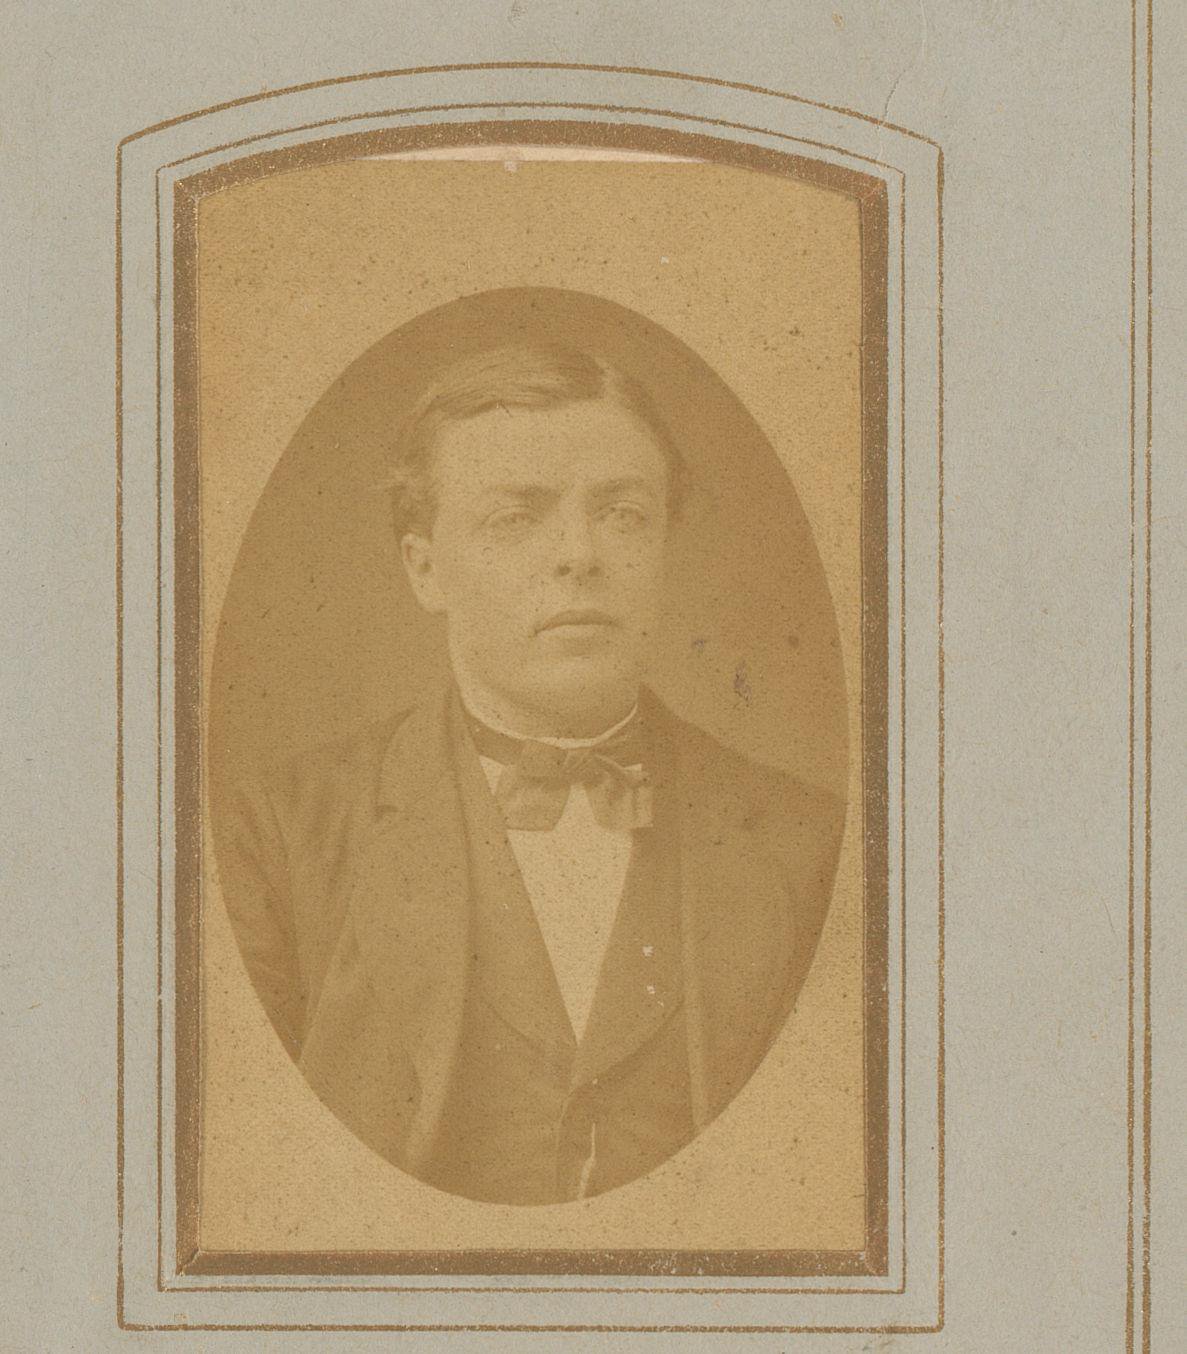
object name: album leaf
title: Portret van een man met vlinderstrik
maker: eduard heinrich joseph weismuller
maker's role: fotograaf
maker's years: 1849-1897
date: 1875-1897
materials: cardboard, photographic support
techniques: albumen print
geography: amsterdam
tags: historical persons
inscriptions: inscription: ‘Eduard Weismuller,/ PHOTOGRAPH/ Kalverstraat bij de Munt 201./ AMSTERDAM./ No.’